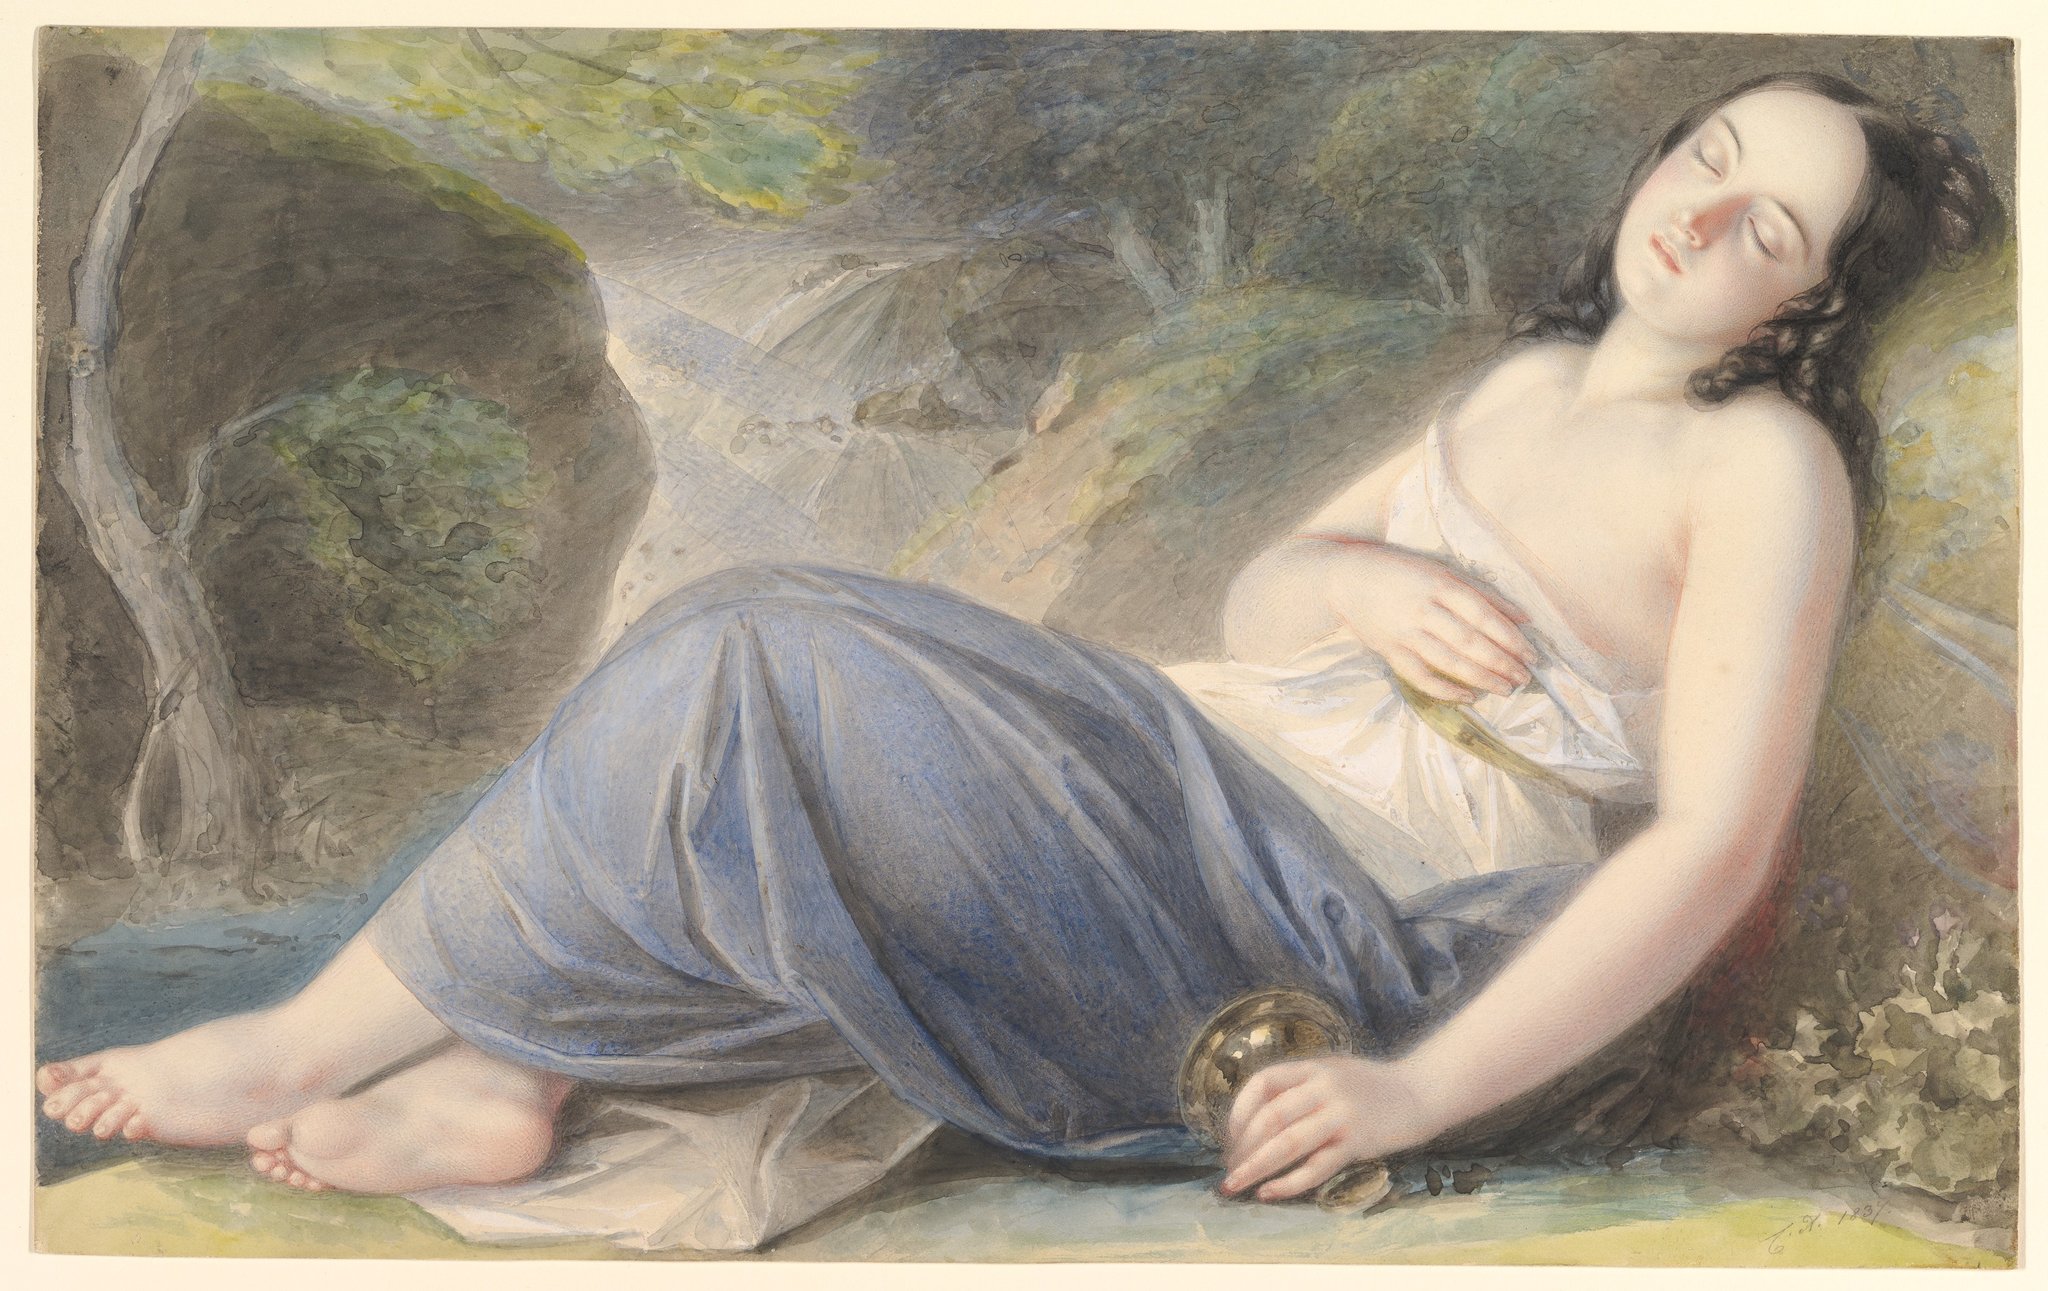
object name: drawing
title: Psyche Asleep in a Landscape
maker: karl joseph aloys agricola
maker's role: artist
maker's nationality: austrian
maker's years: 1779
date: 1837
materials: gouache, graphite, watercolor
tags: sleeping,women,landscapes